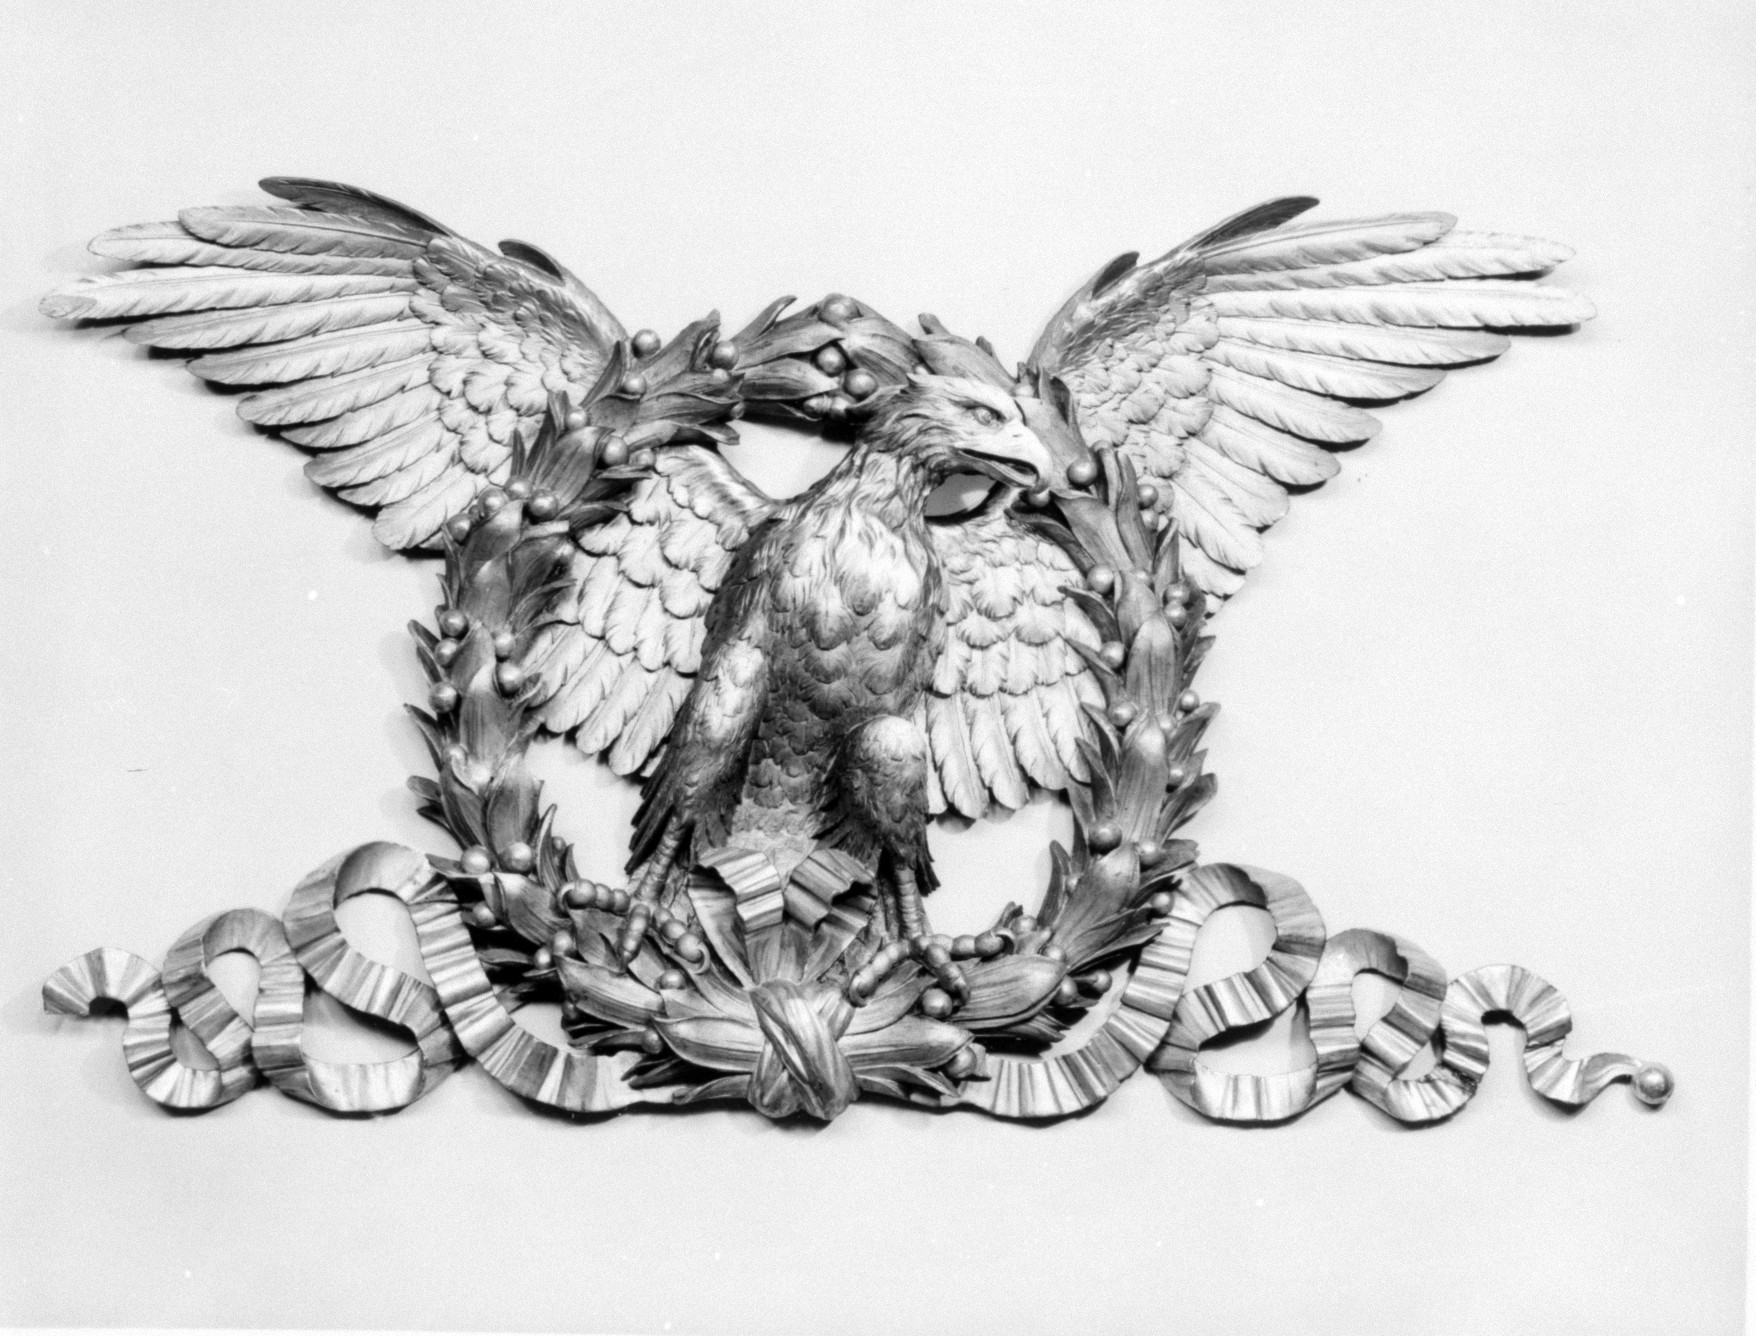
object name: overdoor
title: Overdoor with Eagle and Laurel Wreath (one of a pair)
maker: giocondo (giuseppe) albertolli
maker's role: designer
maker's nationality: italian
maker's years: 1742-1839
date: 1790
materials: wood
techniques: carving, gilding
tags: eagles,garlands